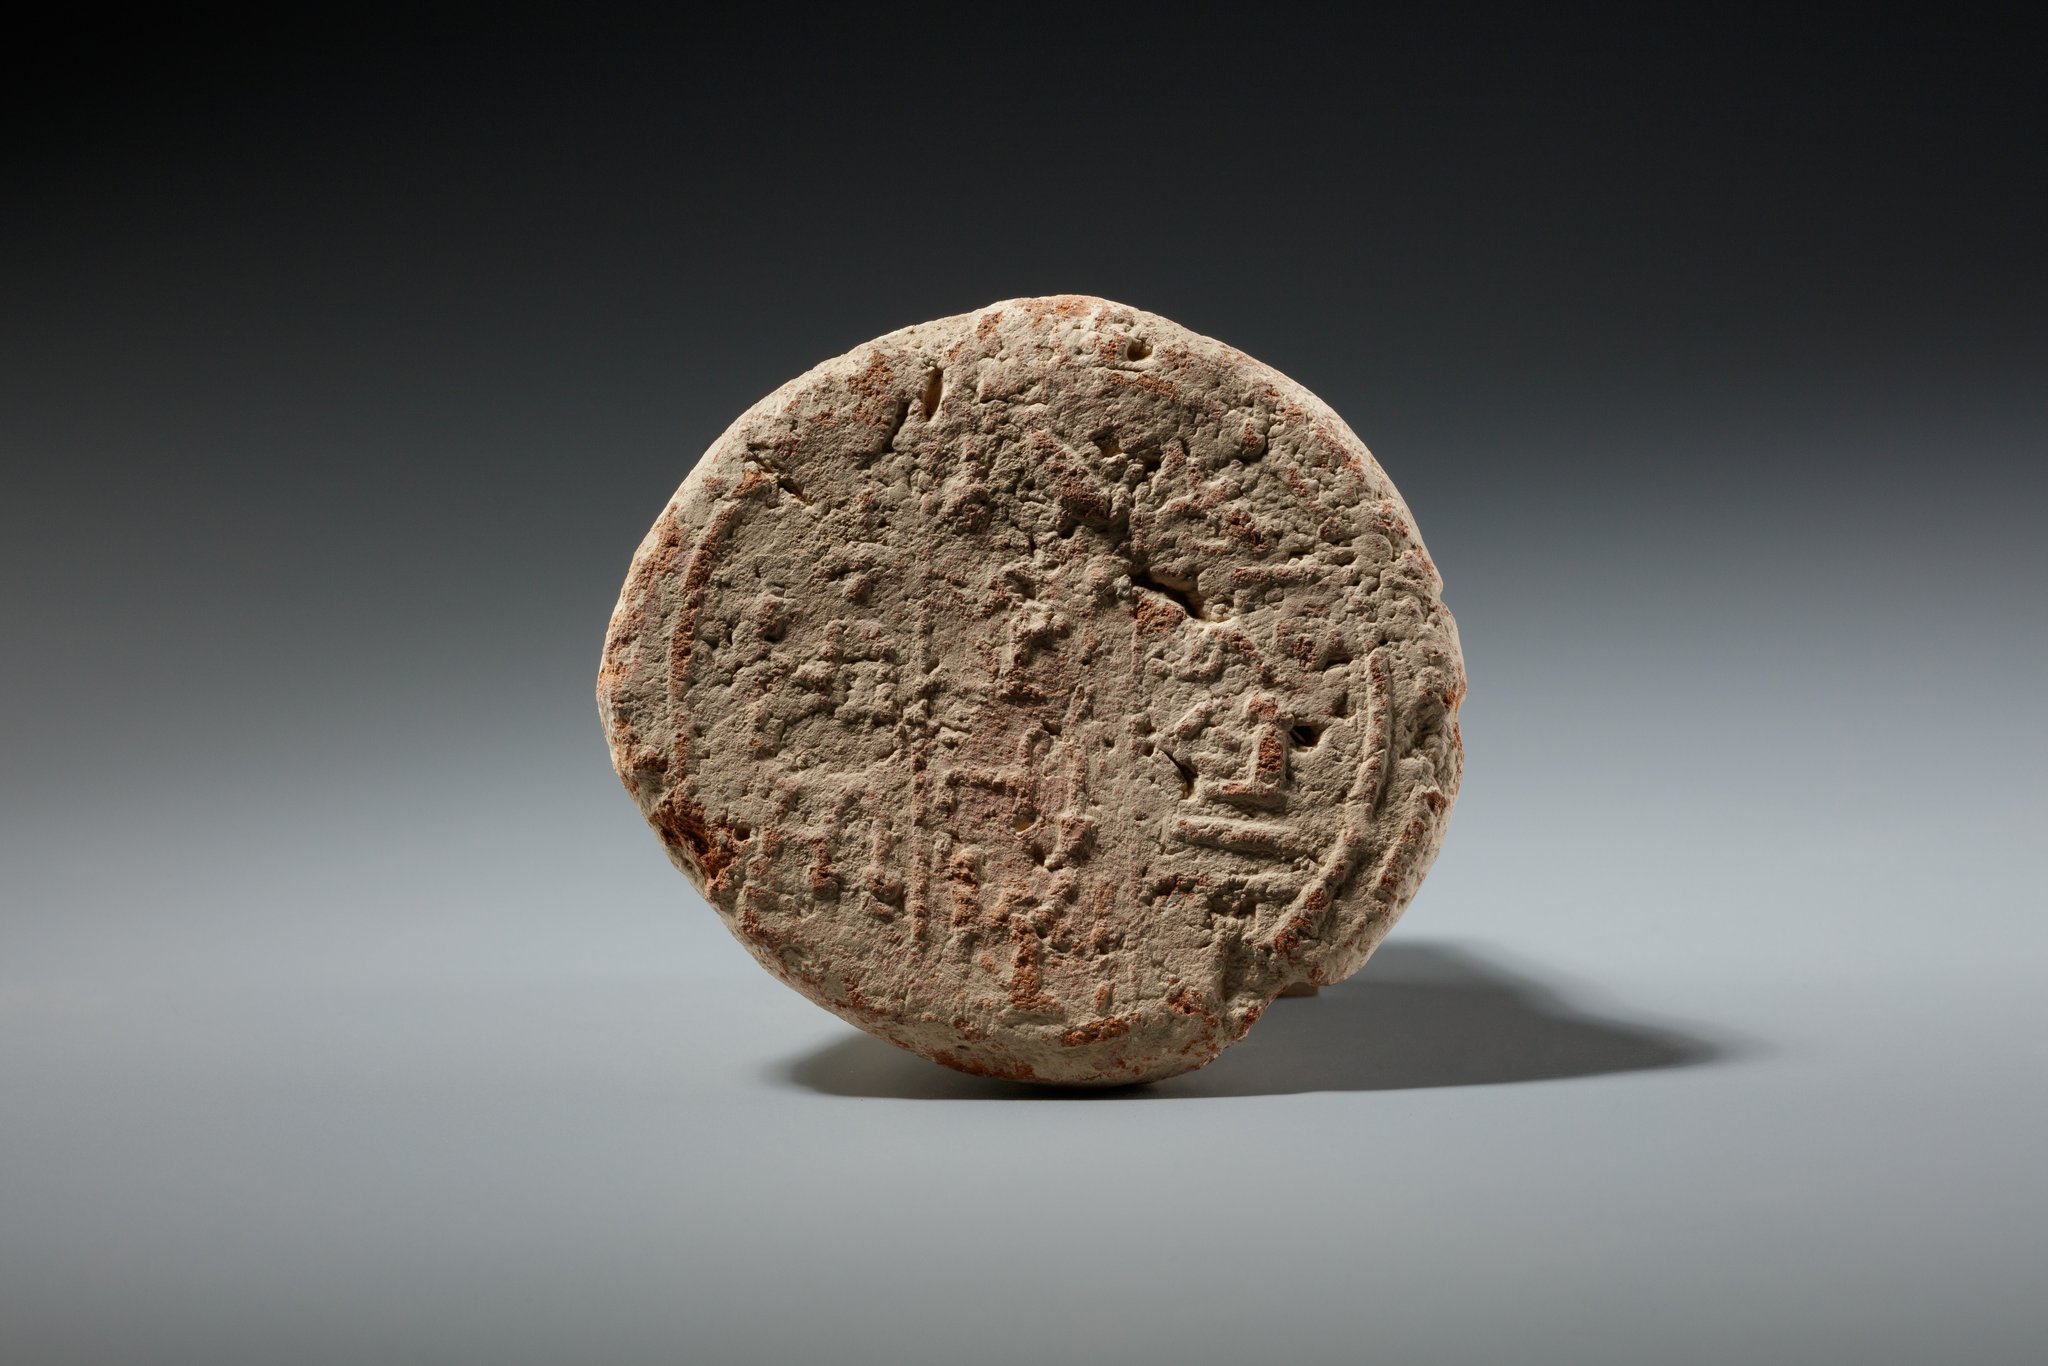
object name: cone, davy 240, tjanuni, royal scribe, recruit, army, tt 74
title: Funerary Cone of the Royal Scribe Tjanuni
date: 1400-1390 BCE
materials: pottery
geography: egypt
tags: hieroglyphs